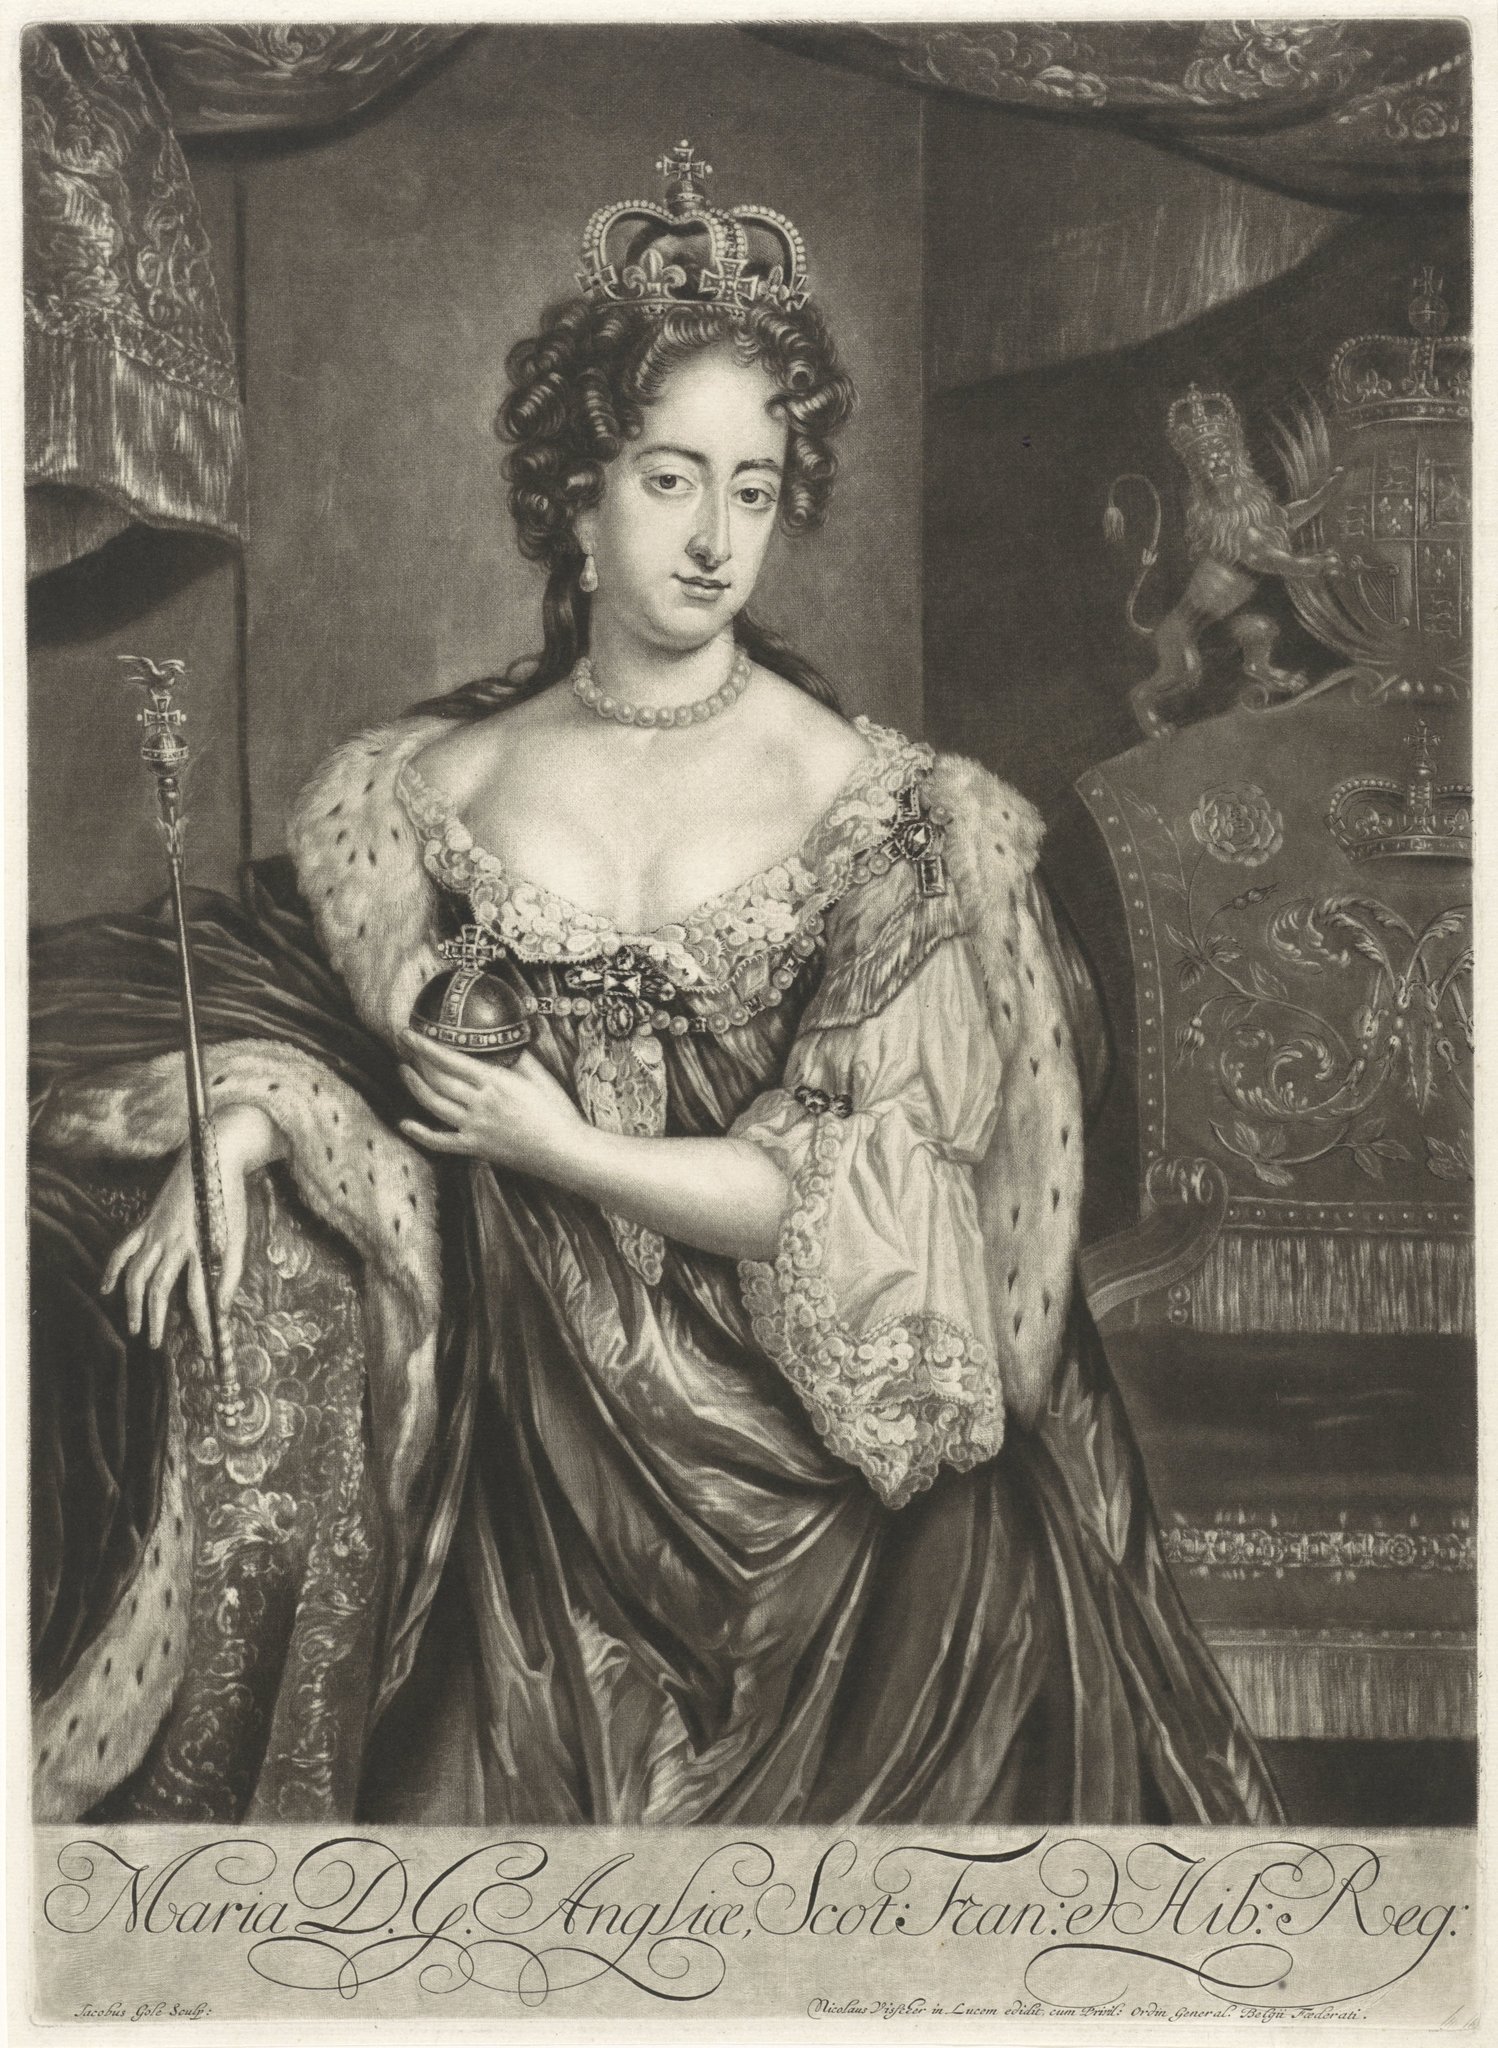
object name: print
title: Portret van koningin Maria II Stuart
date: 1689-1724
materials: paper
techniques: engraving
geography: amsterdam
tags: the hague, william iii (prince of orange and king of england, scotland, and ireland), london, maria ii stuart (koningin van engeland, schotland en ierland), insignia and symbols of sovereignty (crown, diadem, sceptre, orb, seal, standard, cloak, pectoral)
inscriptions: collector's mark: Lugt 2165, collector's mark: Lugt 2259a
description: Maria II Stuart, koningin van Engeland en Schotland, echtgenote van stadhouder-koning Willem III. Ze draagt de kroon en een kroningsmantel. In de handen een scepter en de rijksappel. Achter haar een troon met het gekroonde wapen van Willem III.